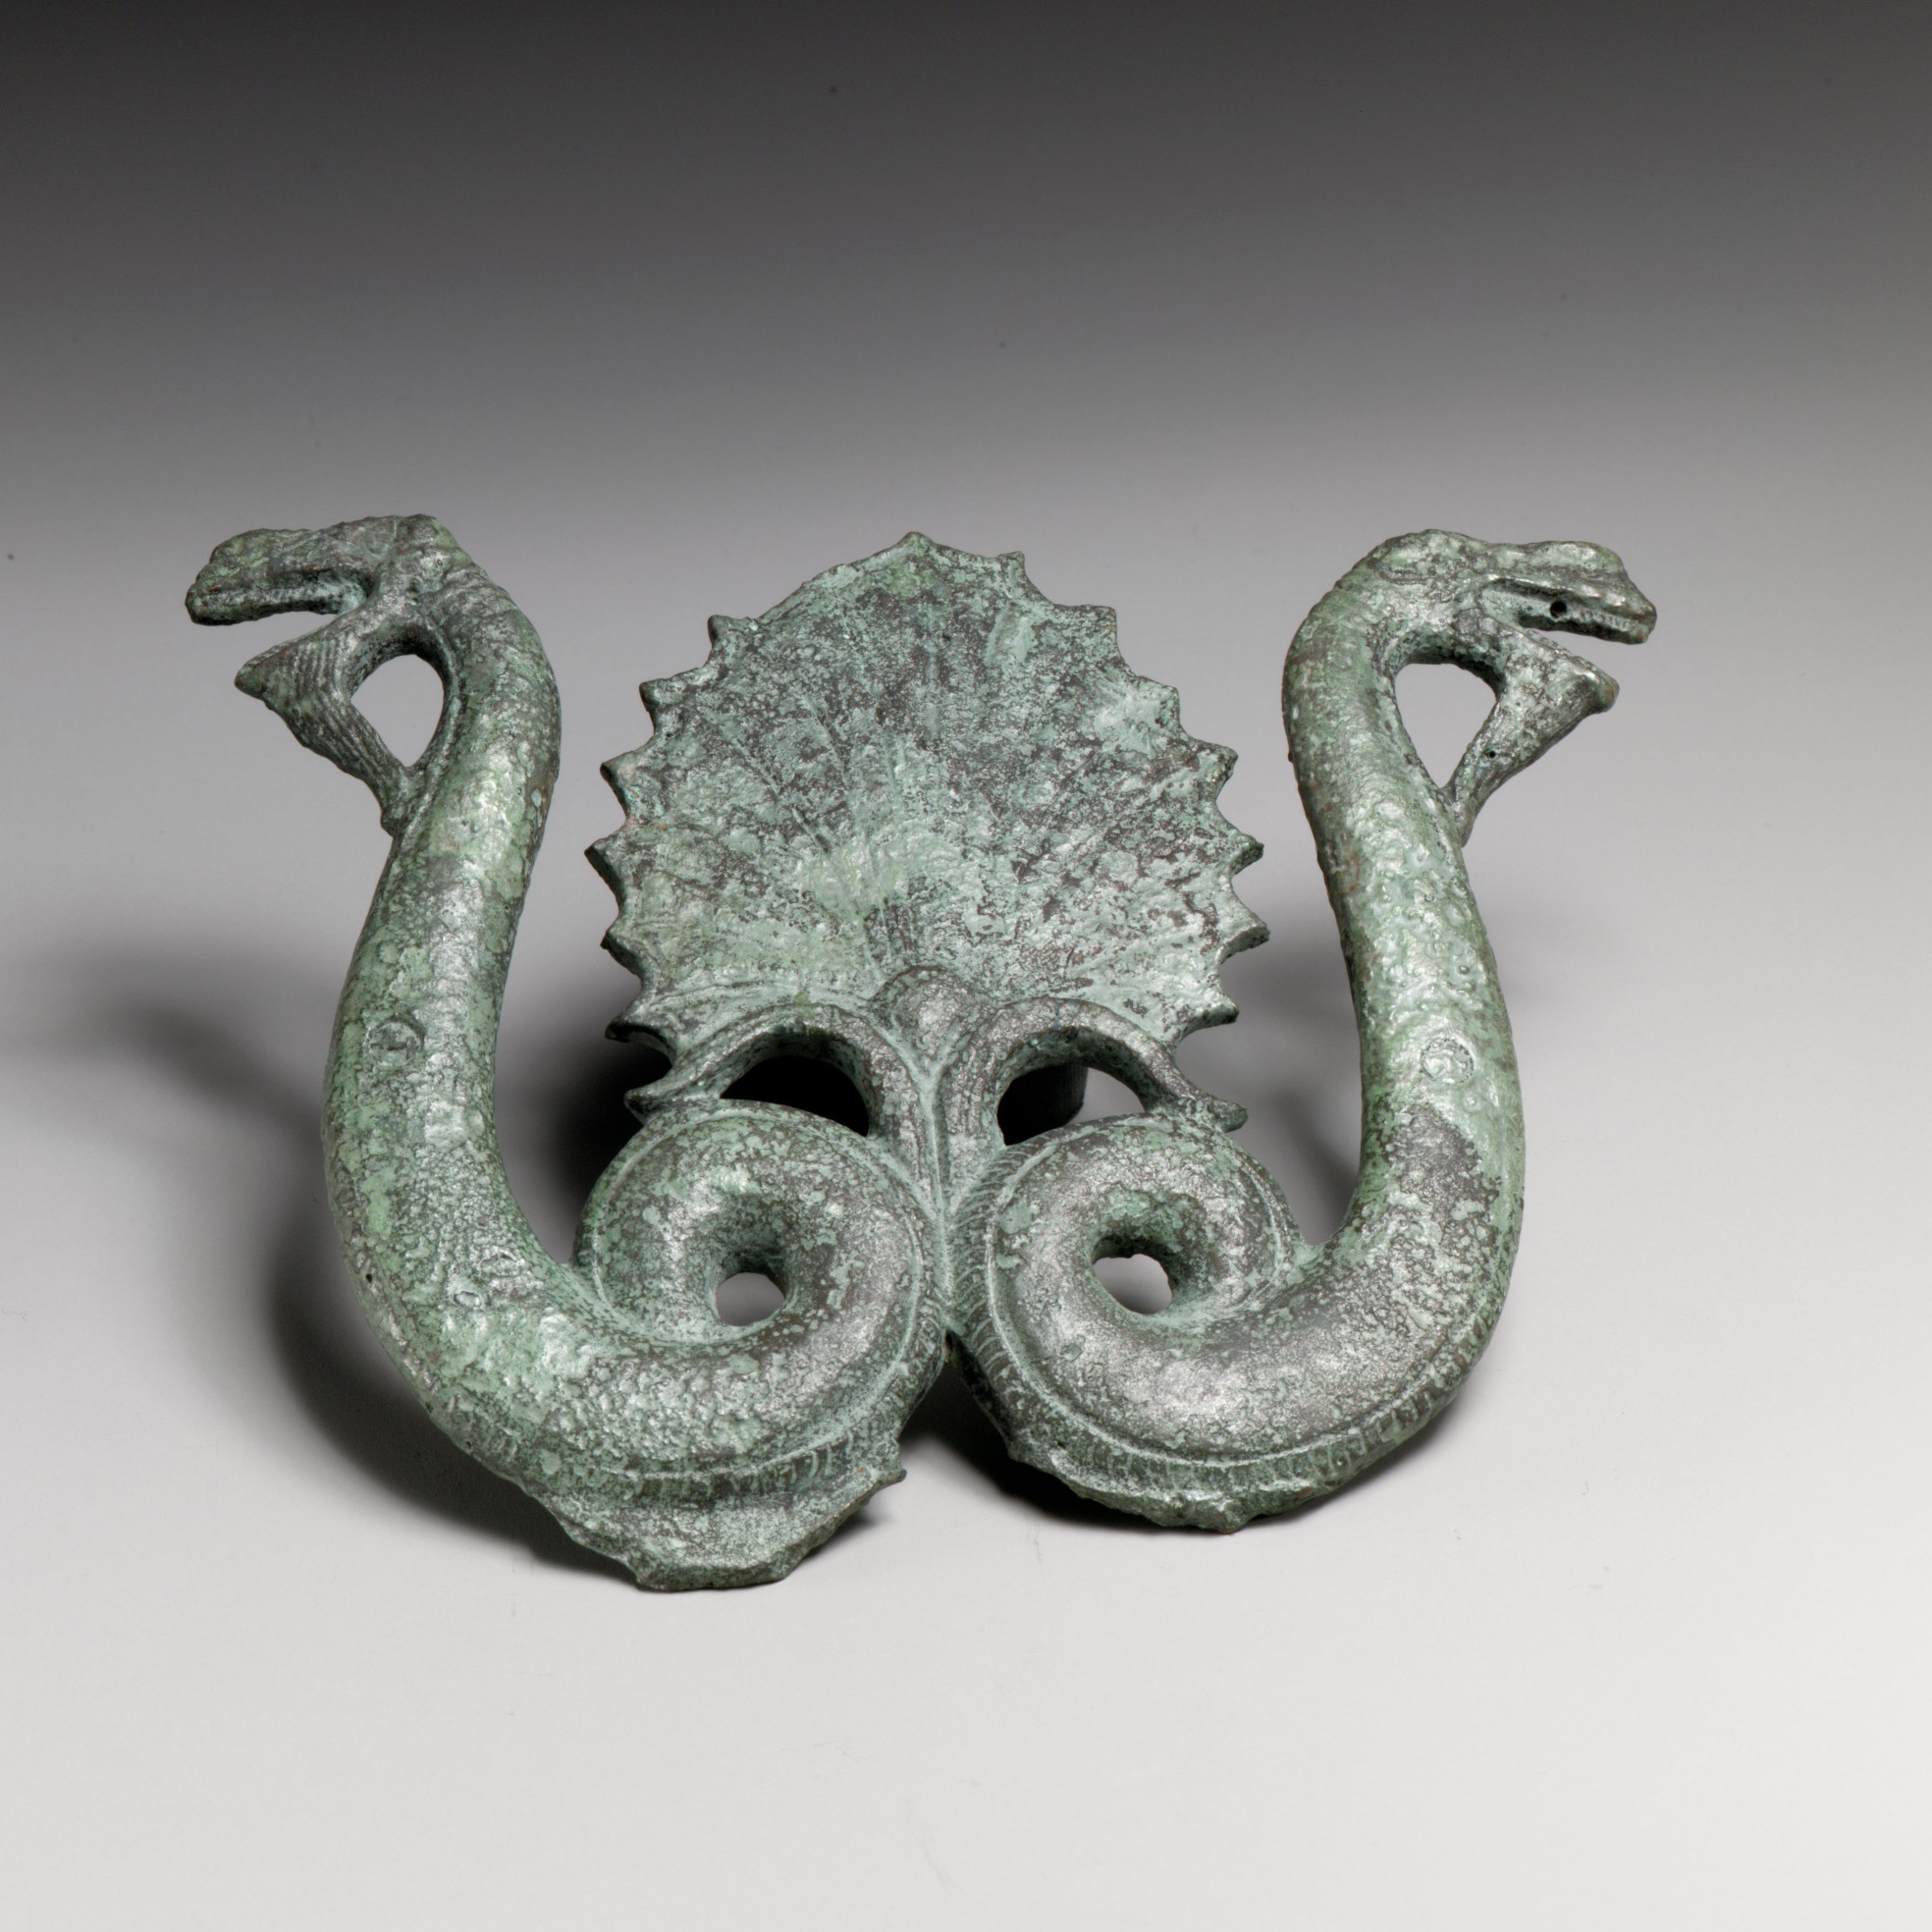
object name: chariot fragment, socket and plaque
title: Fragment of a cart or chariot, plaque with socket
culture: etruscan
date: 500-480 BCE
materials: bronze